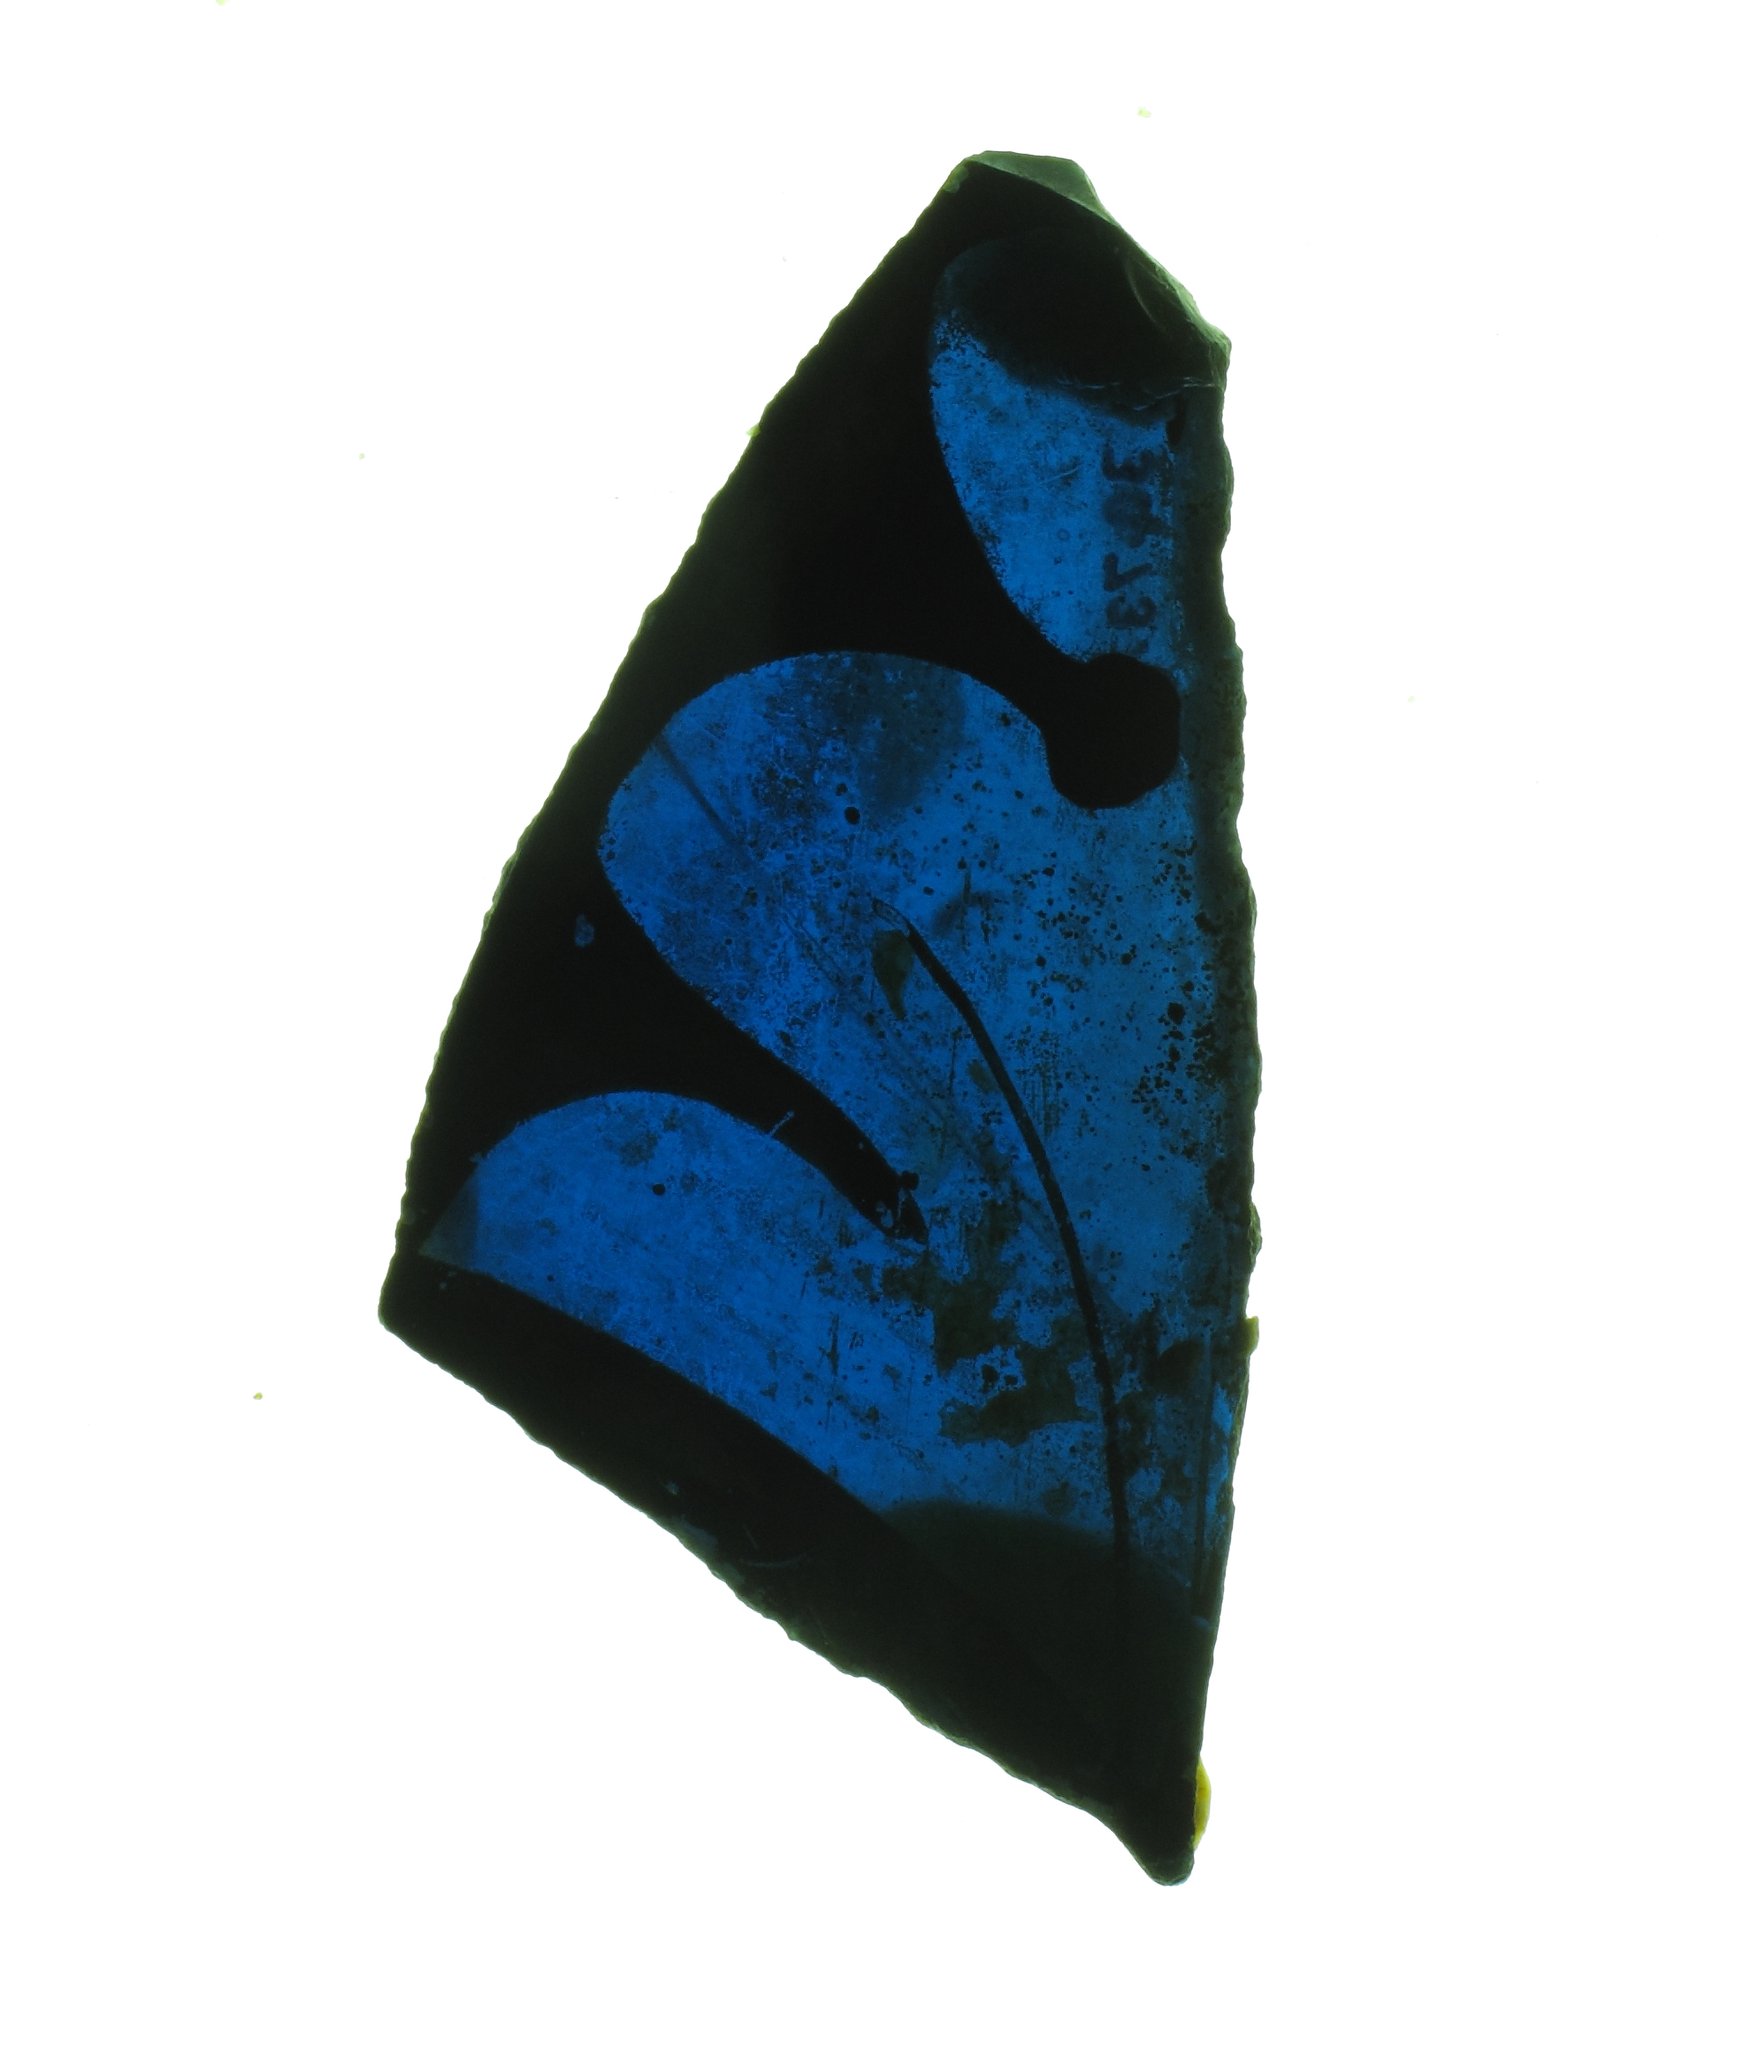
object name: fragment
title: Glass Fragment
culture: european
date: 1201-1400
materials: glass, metal